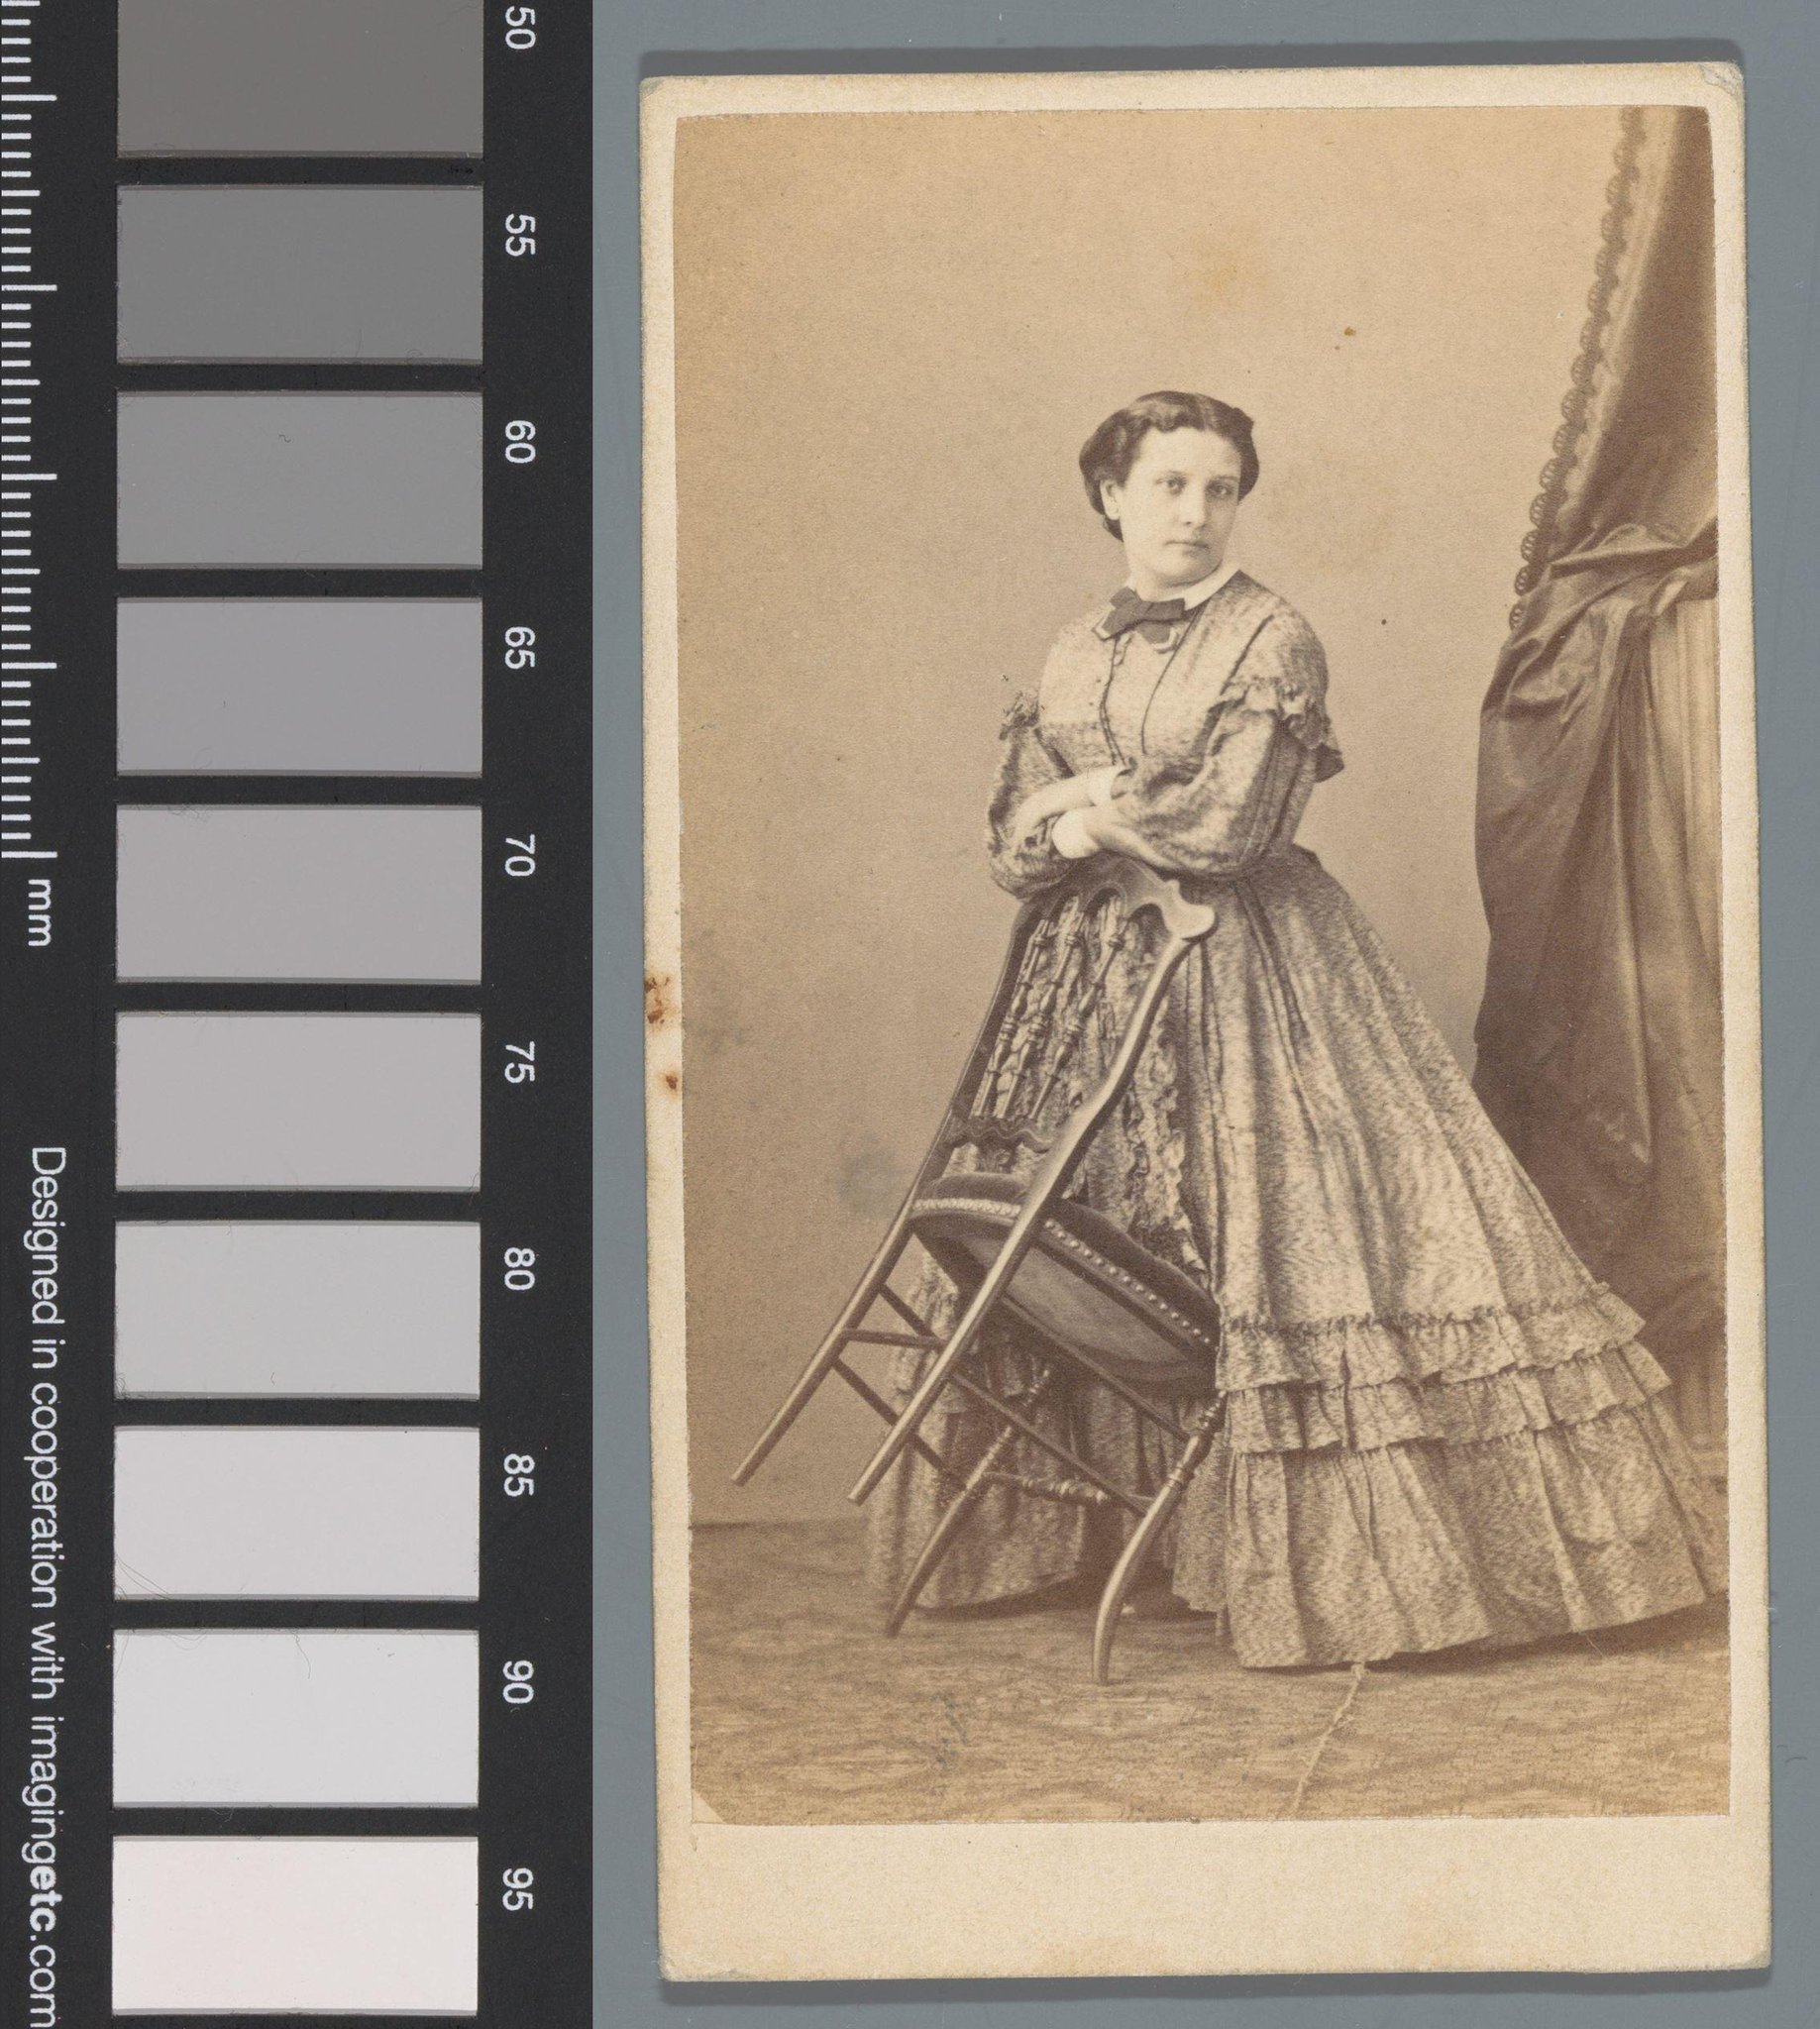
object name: carte de visite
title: Portret van een onbekende vrouw met stoel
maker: bargignac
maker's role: fotograaf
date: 1864-1875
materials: cardboard, paper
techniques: albumen print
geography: marseille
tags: adult woman, anonymous historical person portrayed, chair, marseille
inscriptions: inscription: ‘Photographie/ de/ De Jongh & Bargignac/ 15, Cannebière, 15/ Marseille.’